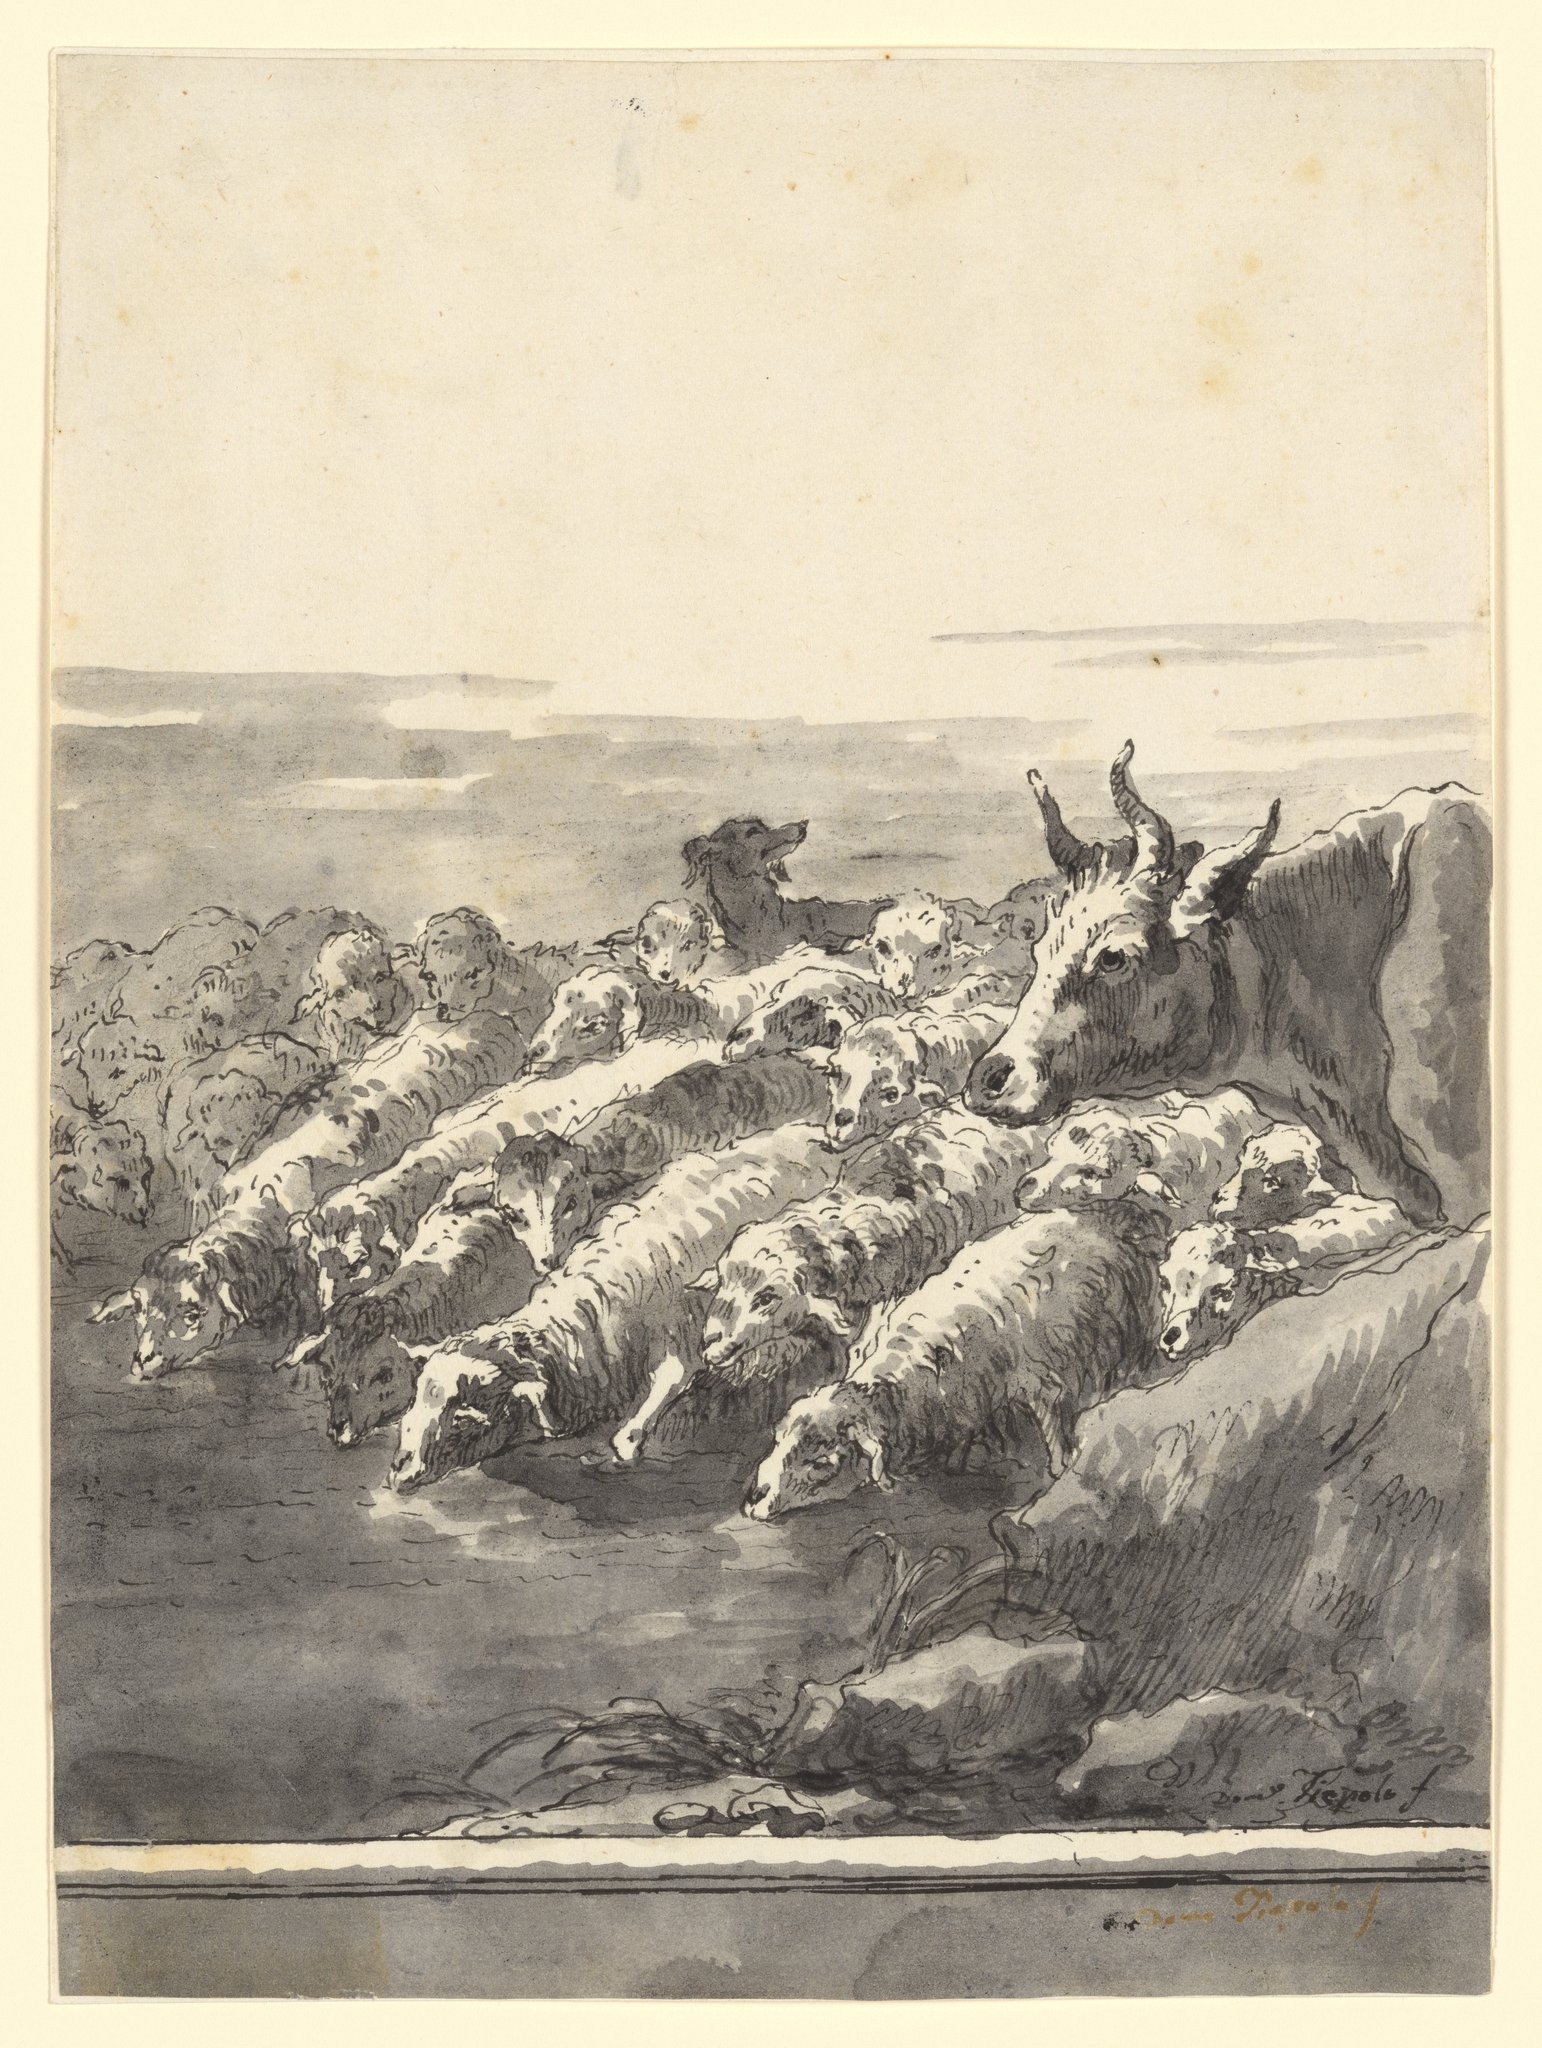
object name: drawing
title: A Flock of Sheep Drinking at a Pool, with a Bullock and a Dog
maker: giovanni domenico tiepolo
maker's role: artist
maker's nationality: italian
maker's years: 1727-1804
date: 1763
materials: ink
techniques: pen, wash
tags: dogs,sheep,drinking